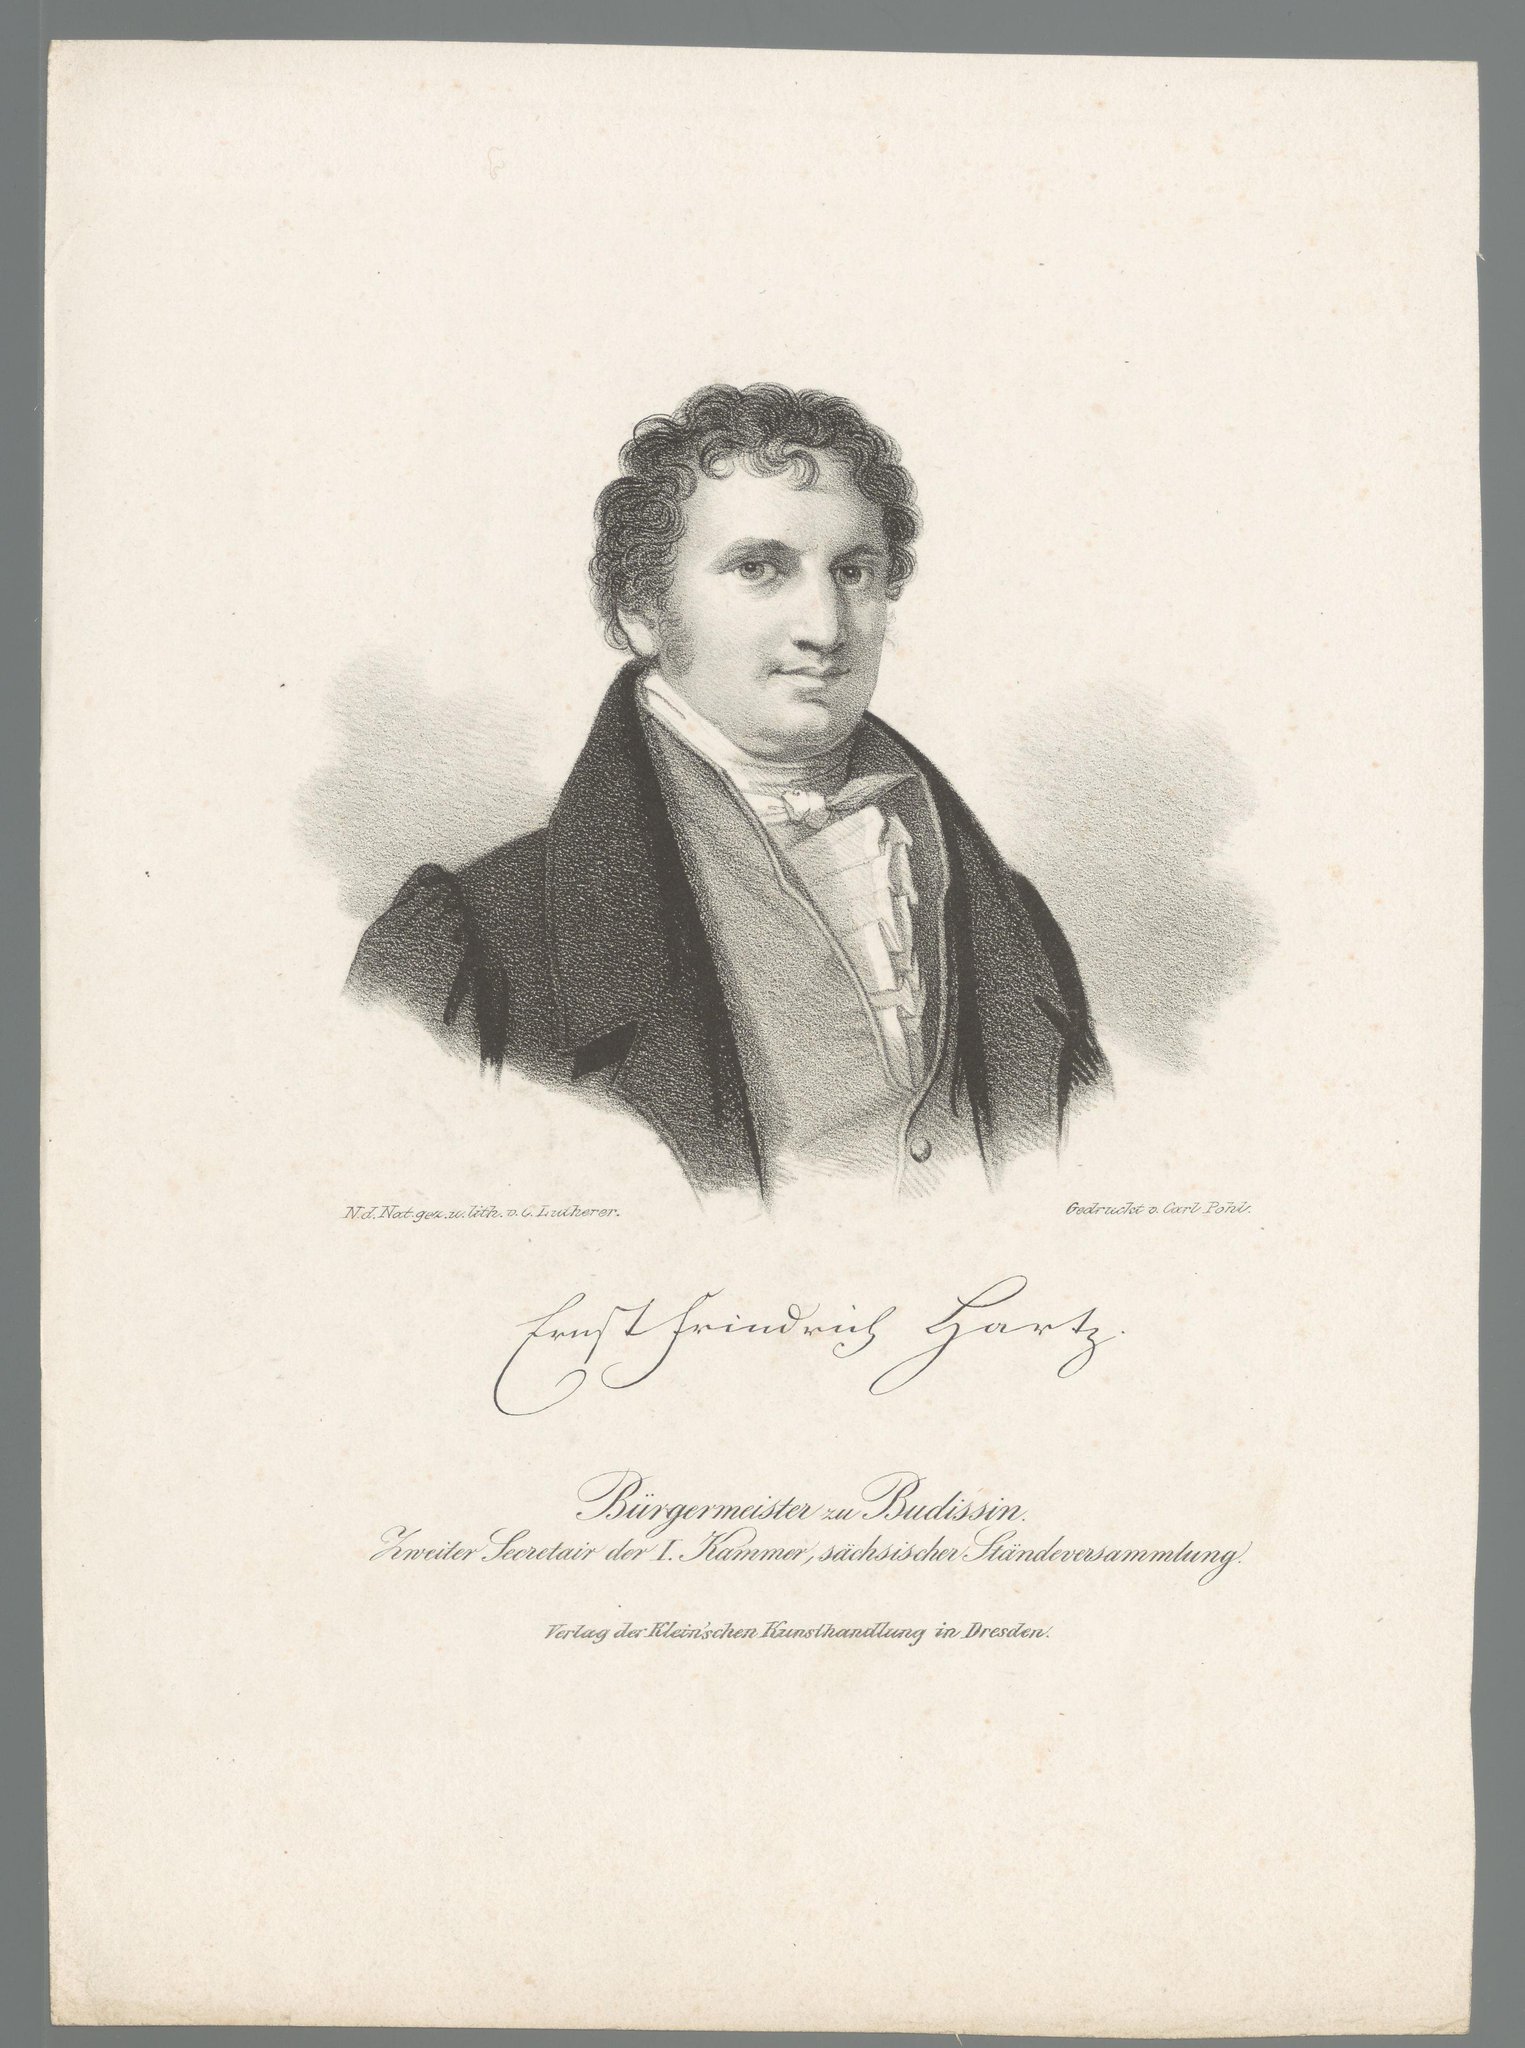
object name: print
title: Portret van Ernst Friedrich Hartz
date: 1817-1850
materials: paper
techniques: lithograph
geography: dresden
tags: mayor, burgomaster, historical persons not known by name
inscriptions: collector's mark: Lugt 2228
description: Portret van een verder onbekende burgemeester met de naam Ernst Friedrich Hartz.